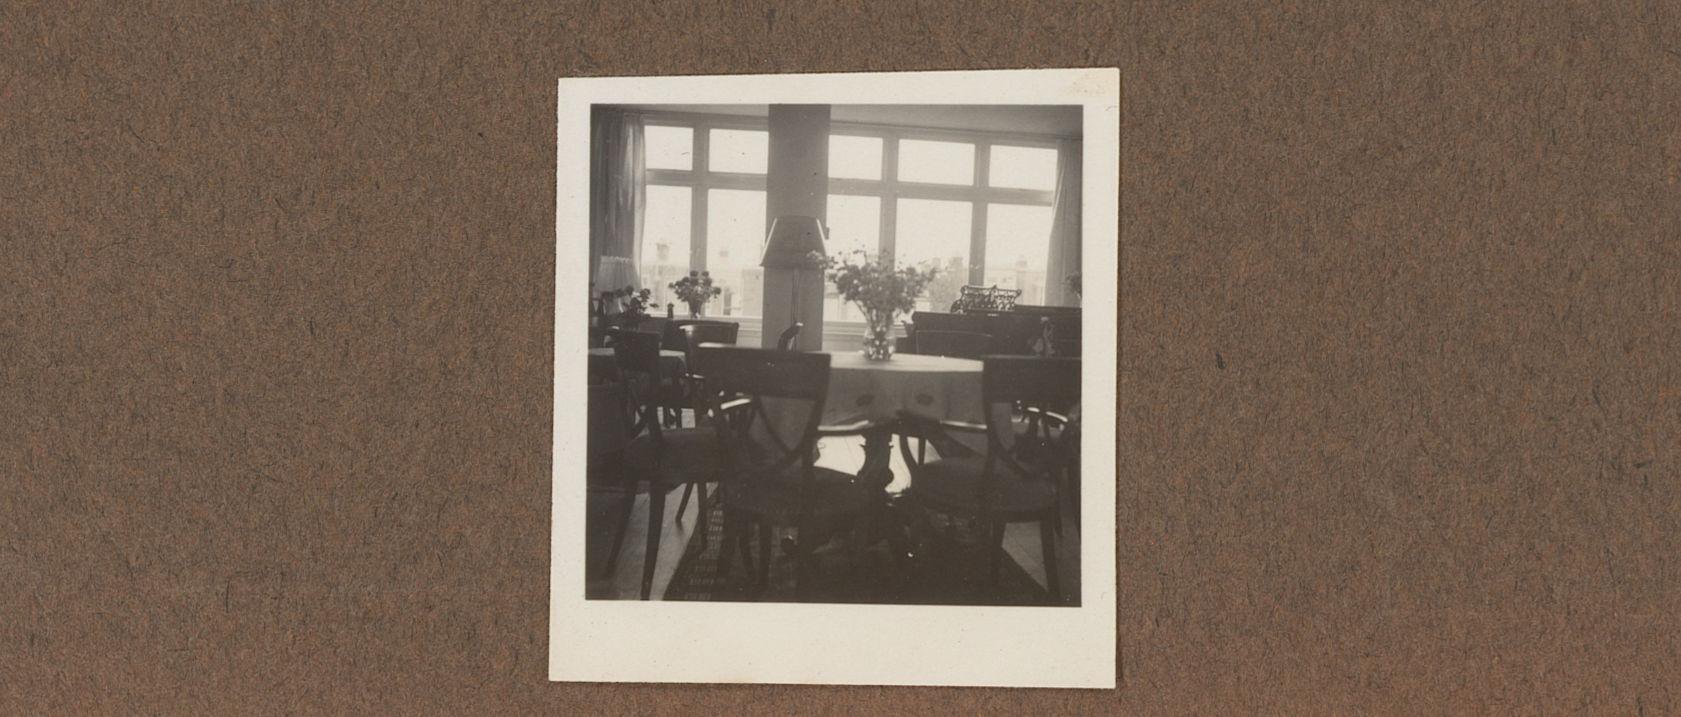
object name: photograph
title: Eethoek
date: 1900-1920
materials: photographic support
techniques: photography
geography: amsterdam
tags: amsterdam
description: Foto op bruin albumblad 56 van familiealbum van Alphons Diepenbrock.